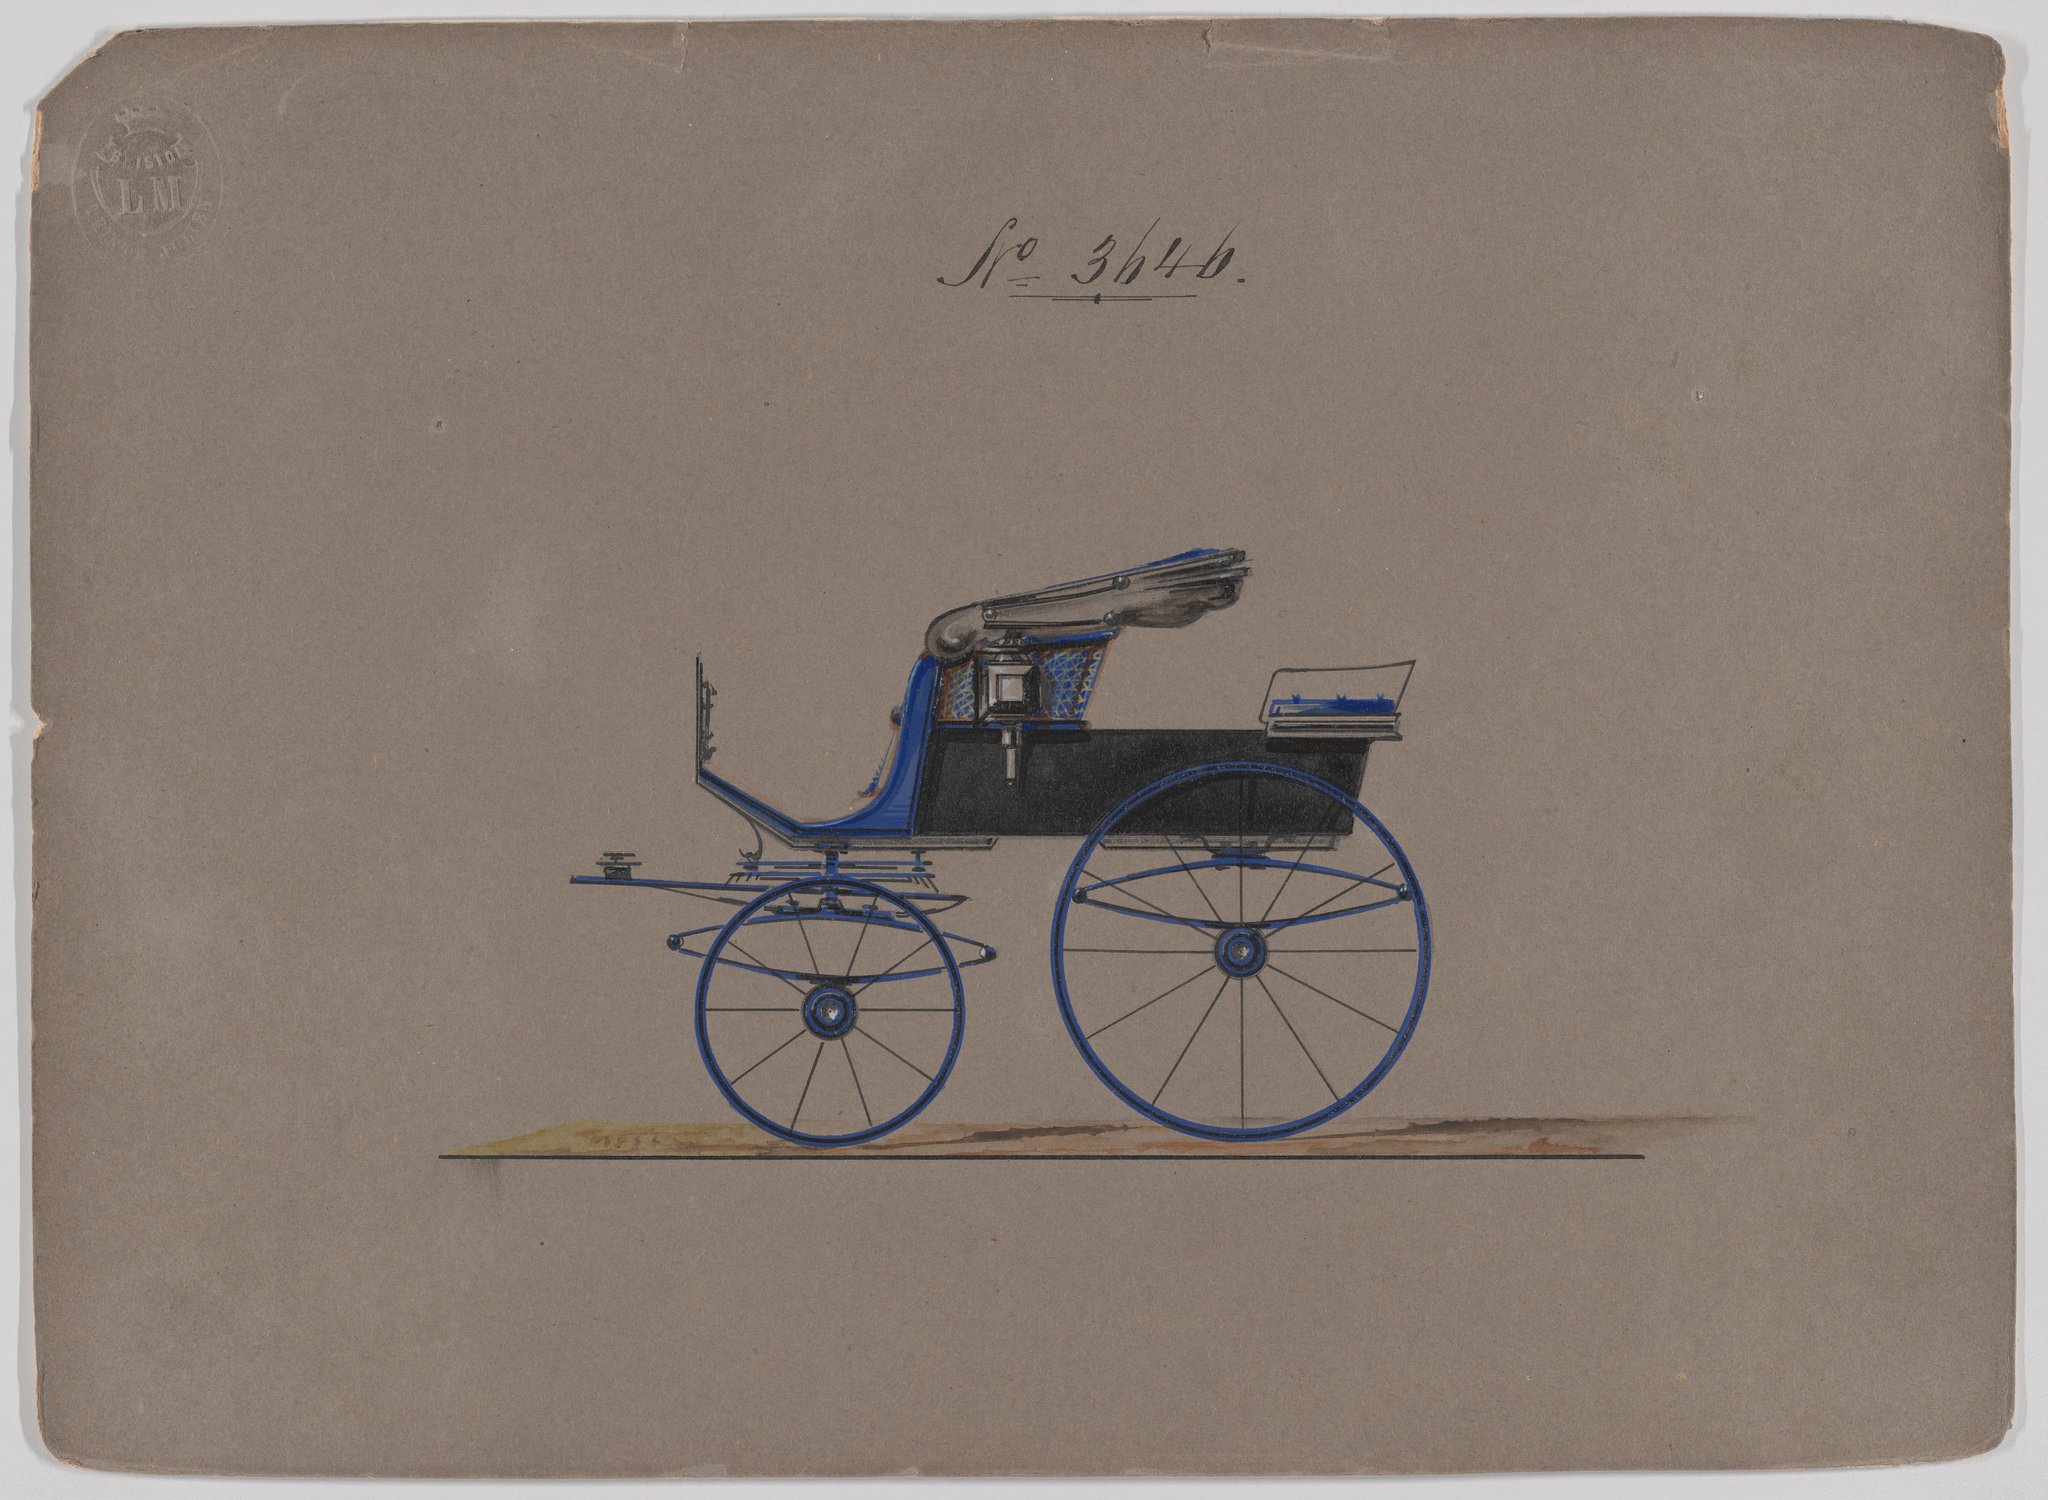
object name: drawing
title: Design for Stanhope Phaeton, no. 3646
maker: brewster & co.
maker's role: manufacturer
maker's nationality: american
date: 1880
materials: gouache, gum arabic, ink, watercolor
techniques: pen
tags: carriages